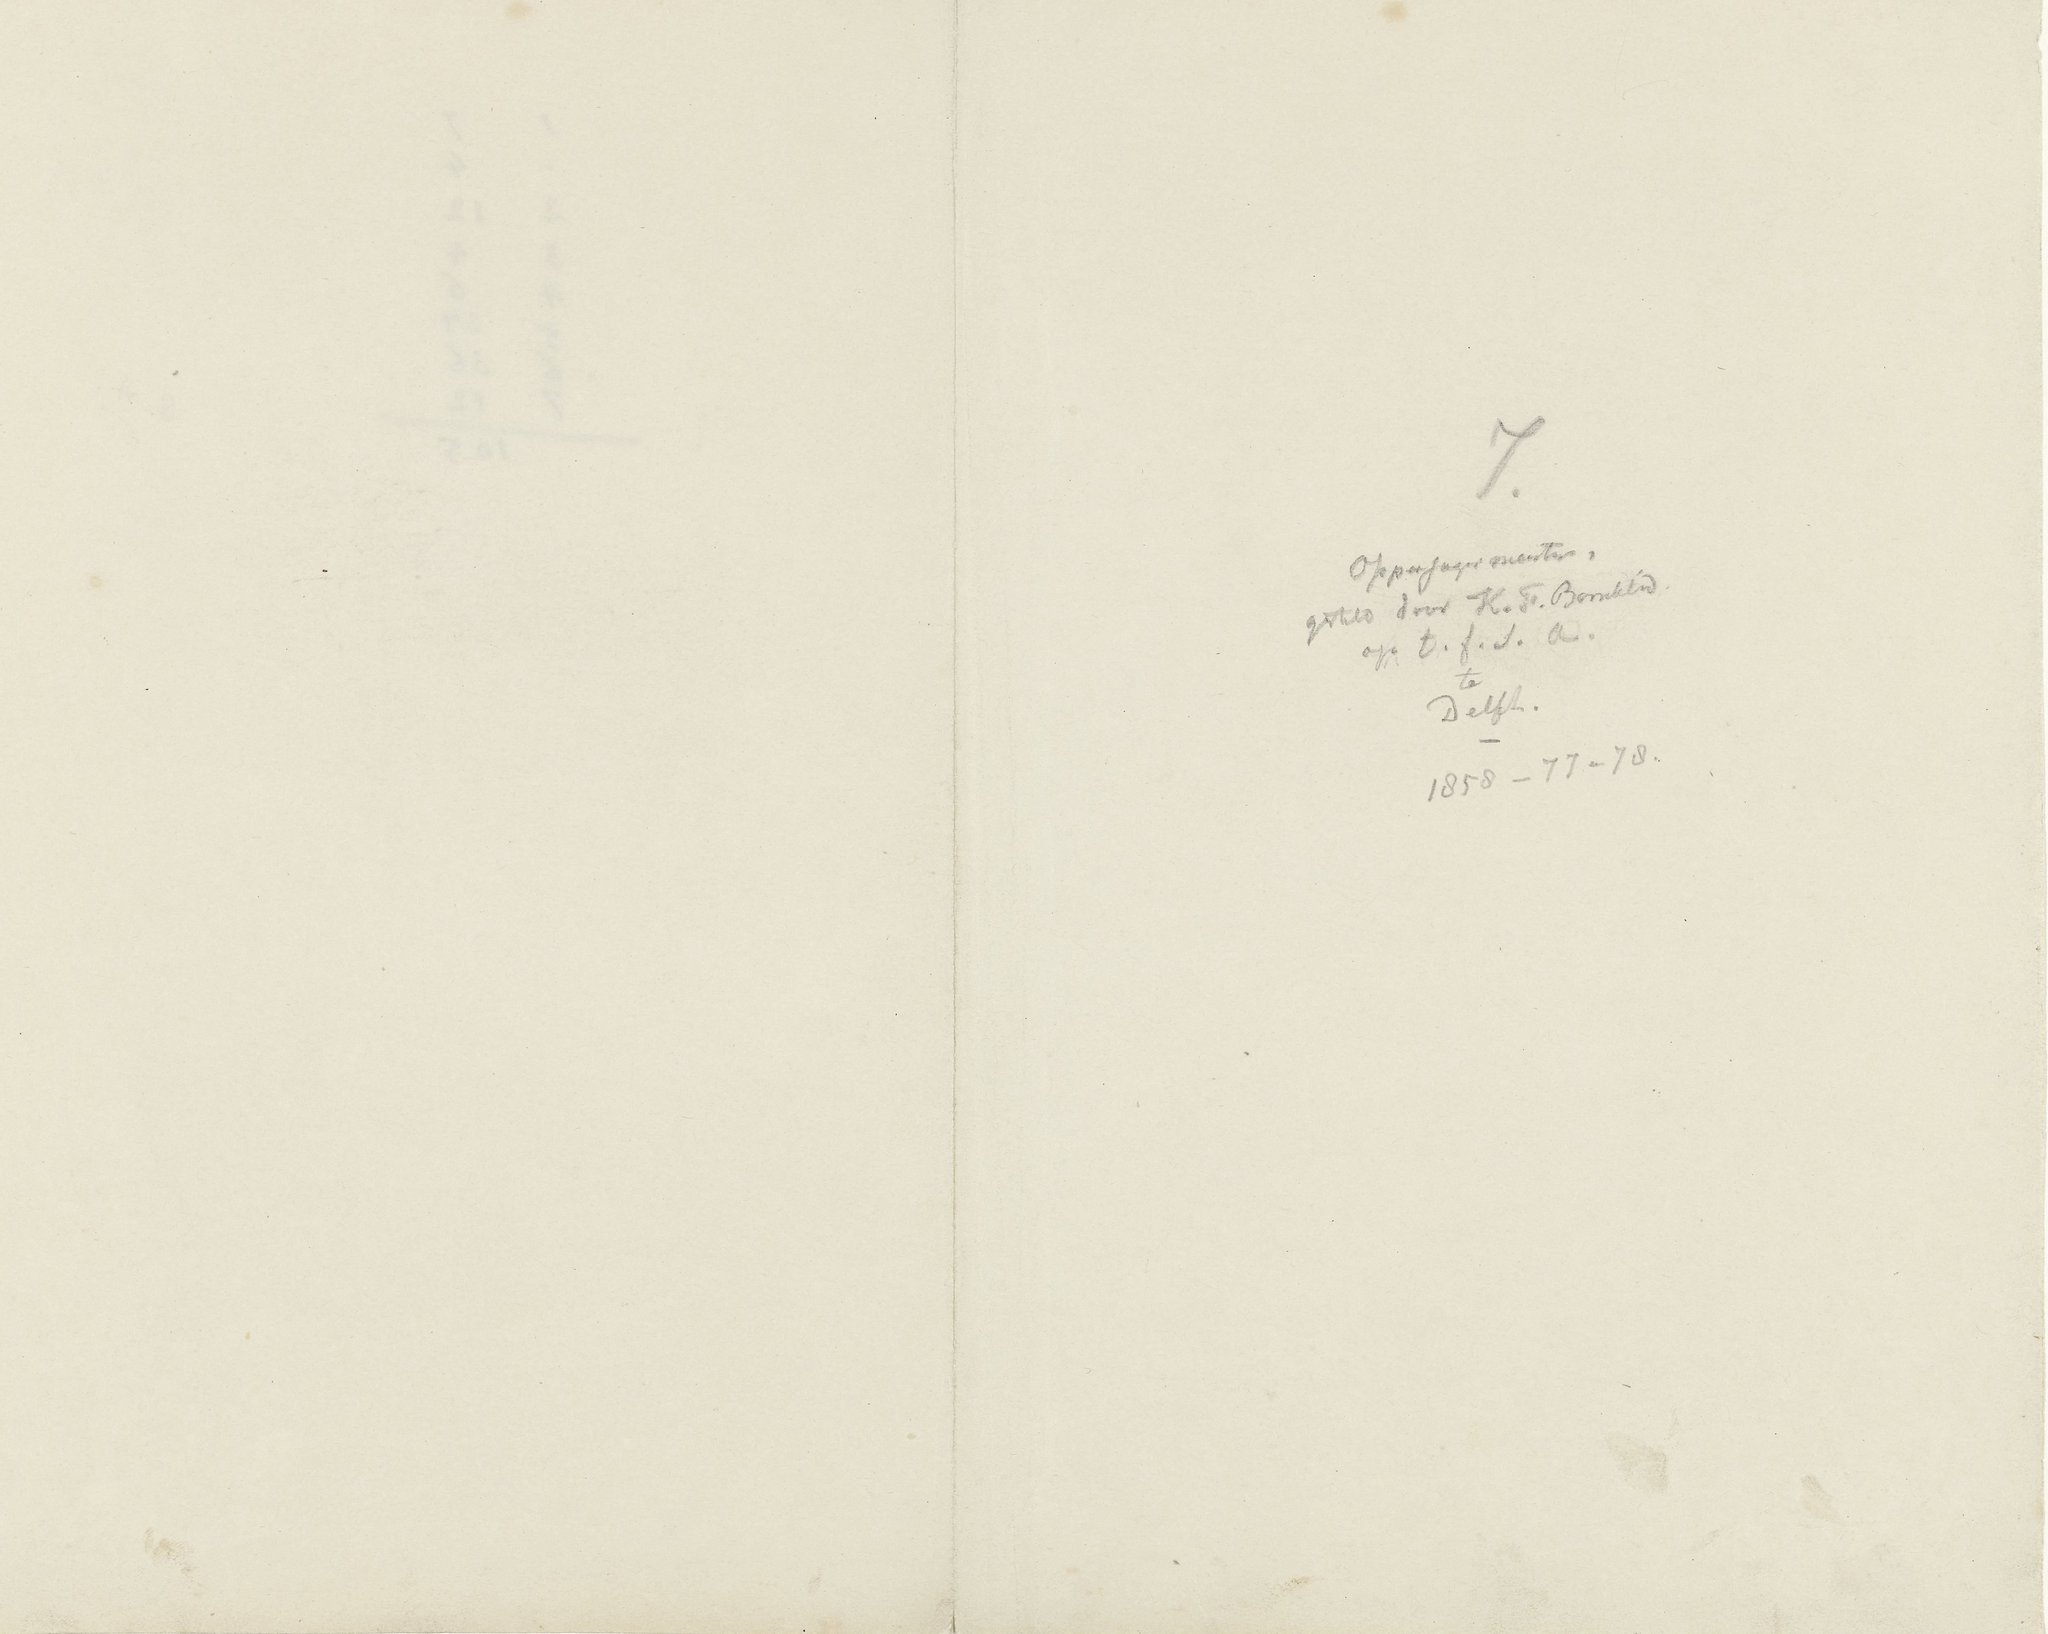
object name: wrapper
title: Omslag voor de verschillende staten van de prent 'Portret van een onbekende man met kap' door Cornelis van der Grient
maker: cornelis van der griendt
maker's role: draughtsman, painter, print maker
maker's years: 1827-1918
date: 1858-1918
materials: paper, pencil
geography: netherlands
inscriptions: inscription: ‘[...] 105, 8 st’